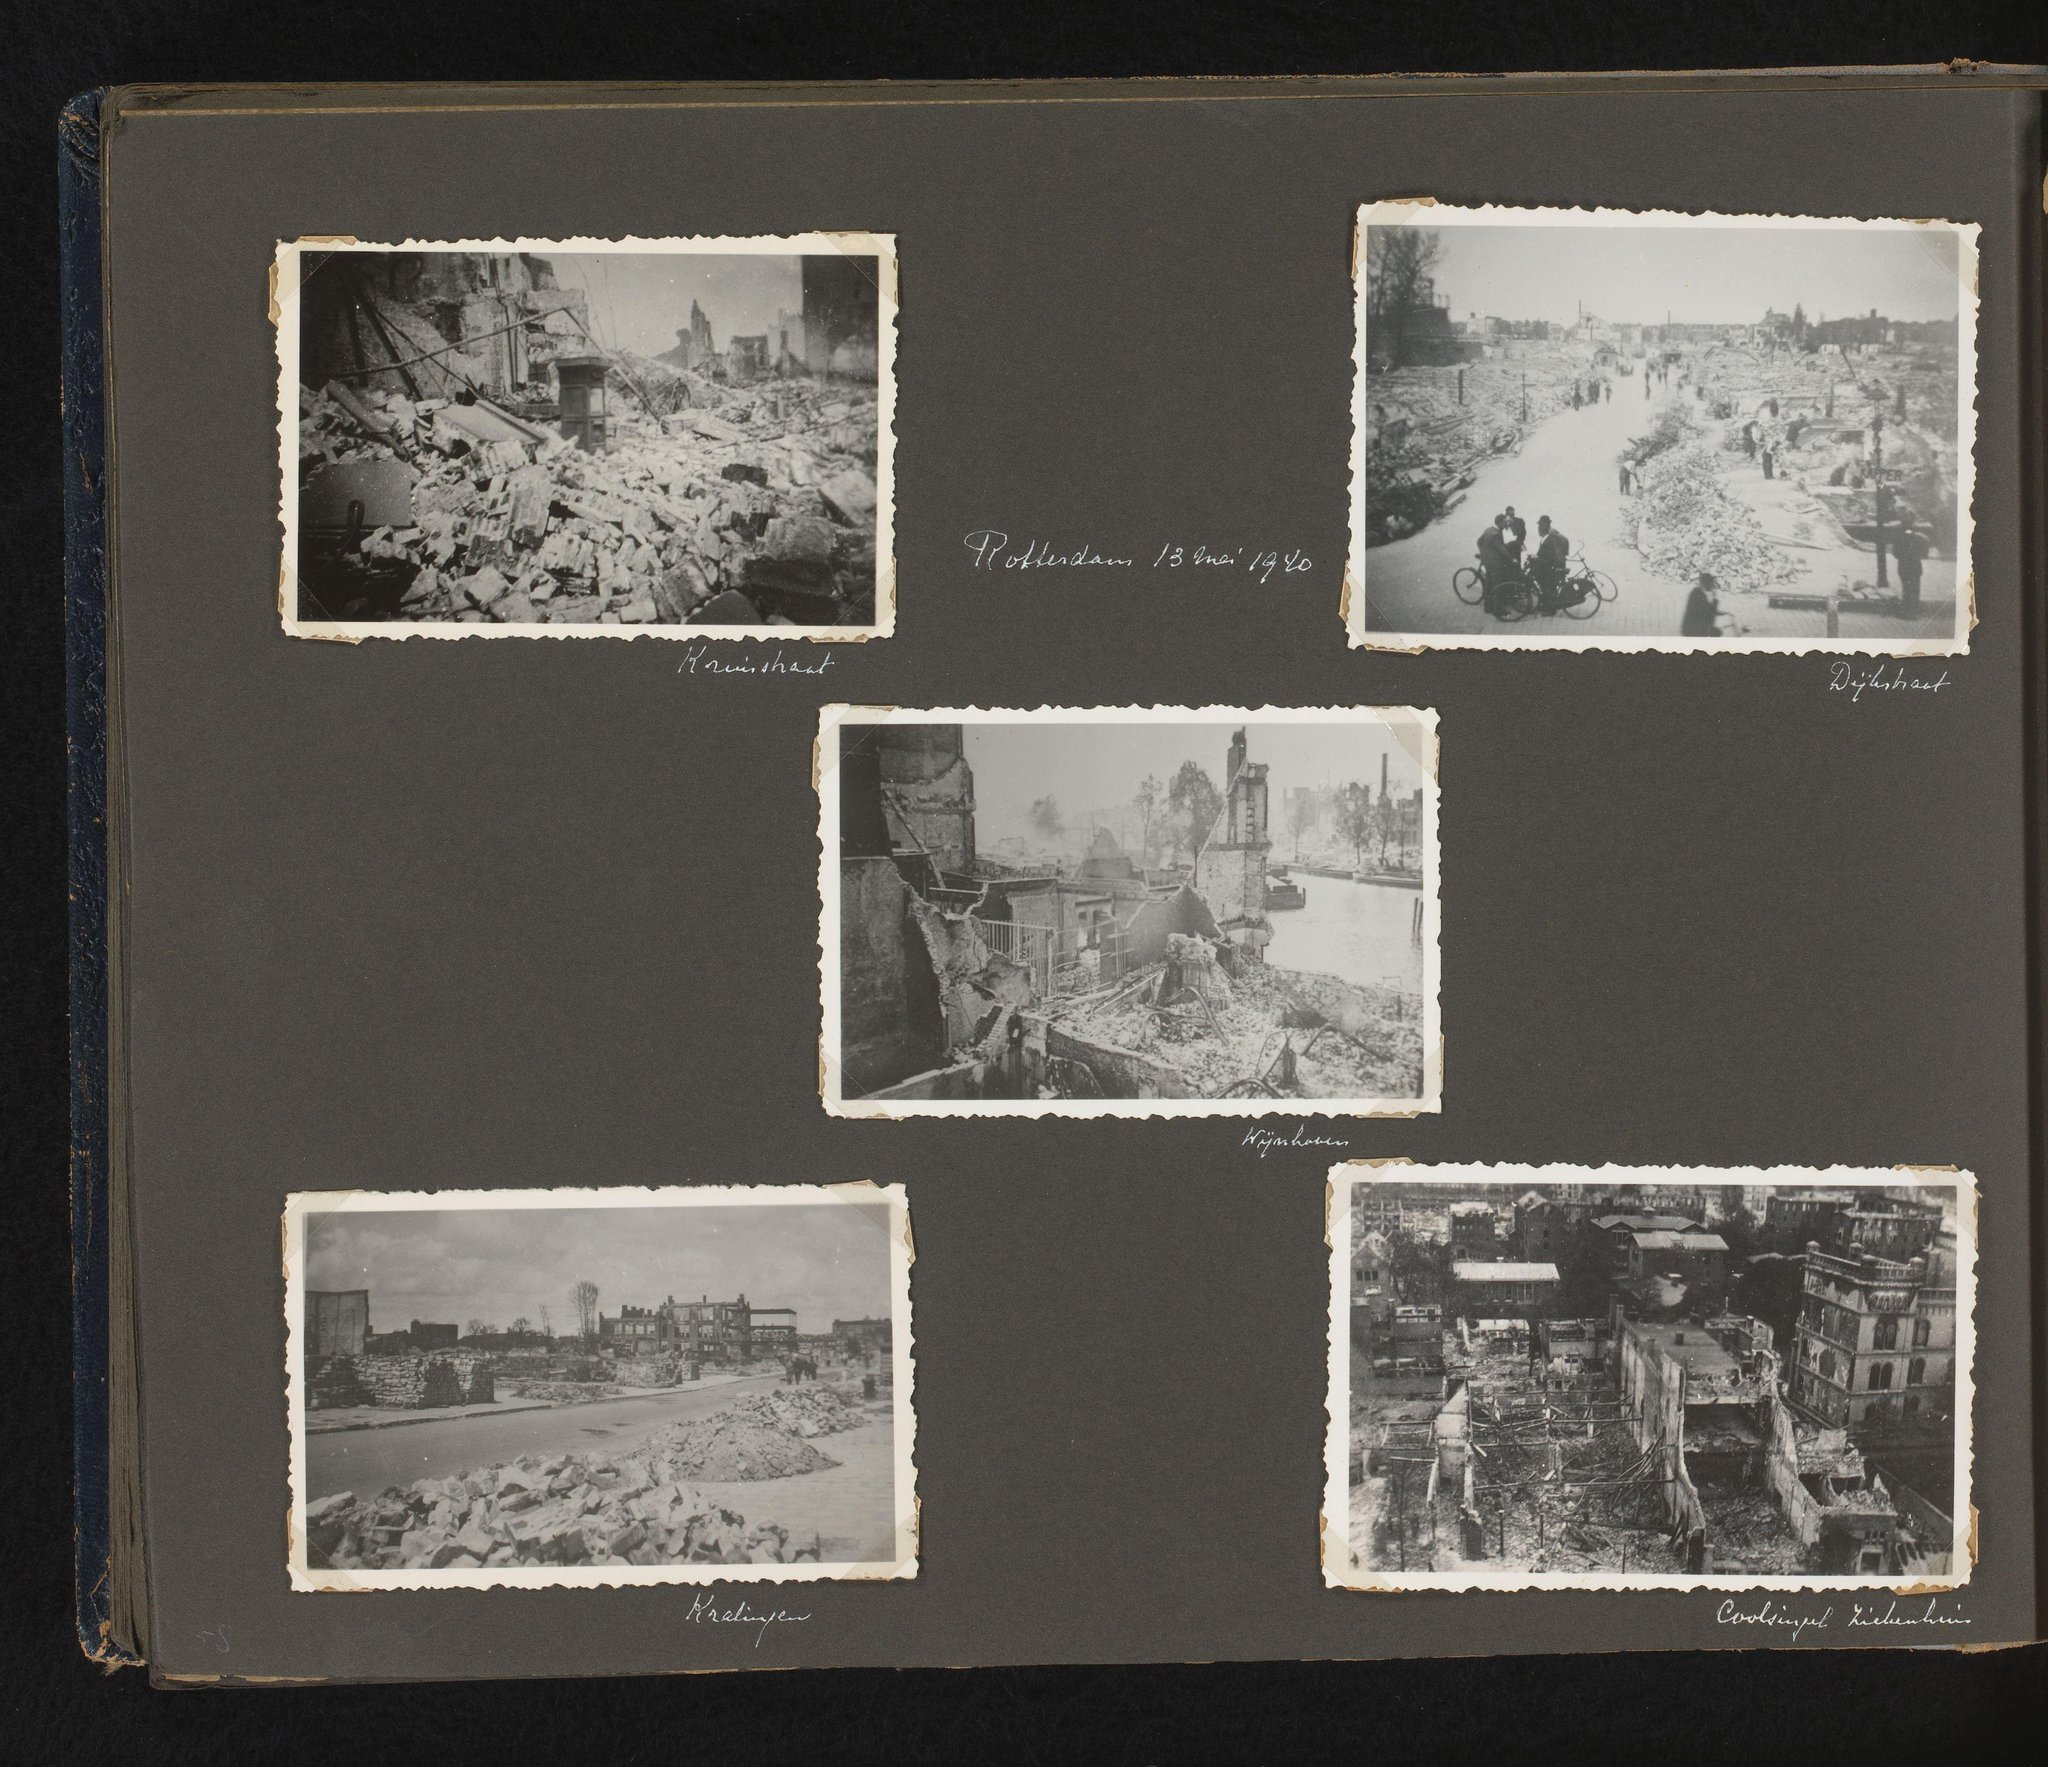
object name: photograph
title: Ruïnes van Rotterdam na het bombardement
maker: Anonymous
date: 1905-1940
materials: cardboard, photographic support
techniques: gelatin silver print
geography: rotterdam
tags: devastated, ruined place or city (~ warfare), rotterdam, rotterdam blitz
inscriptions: inscription: ‘Rotterdam 13 mei 1940 / Kruisstraat / Dijkstraat / Wijnhaven / Kralingen / Coolsingel Ziekenhuis’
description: Albumblad met vijf foto's van de ruïnes van Rotterdam na het bombardement op 14 mei 1940. Foto's van Kruisstraat, Dijkstraat, Wijnhaven, Kralingen en de Coolsingel. Onderdeel van het fotoalbum over de familie van Oranje-Nassau ten tijde van de Tweede Wereldoorlog.